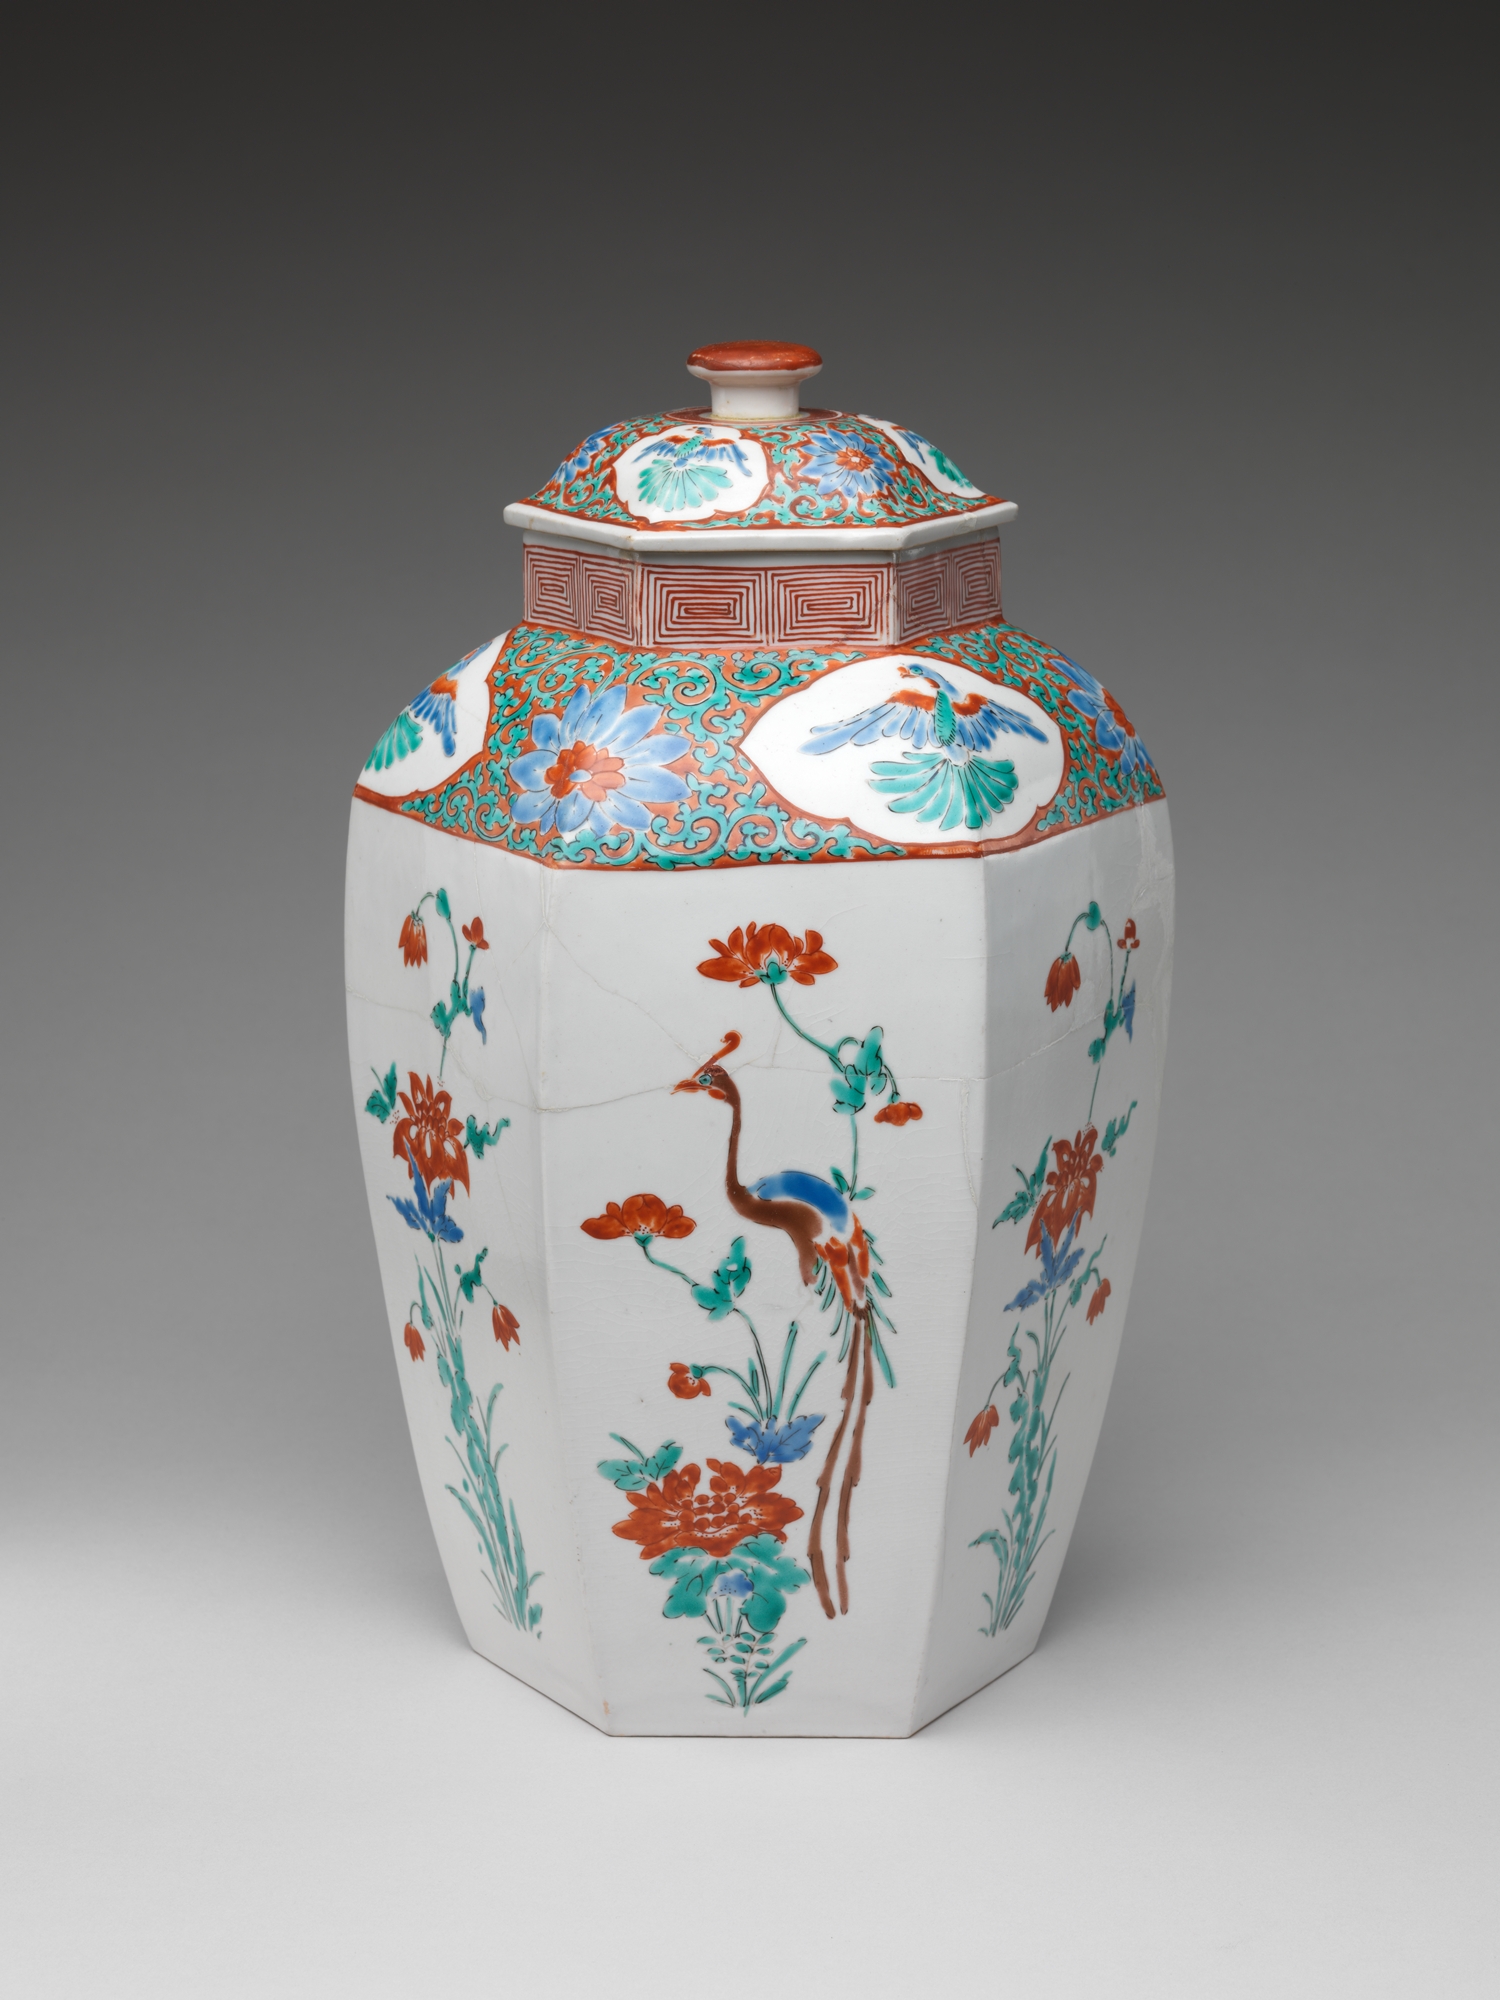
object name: jar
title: Hexagonal Jar with Flower and Bird Decoration (one of a pair)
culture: japanese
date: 1667-1700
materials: enamel, porcelain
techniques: overglaze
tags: birds,flowers